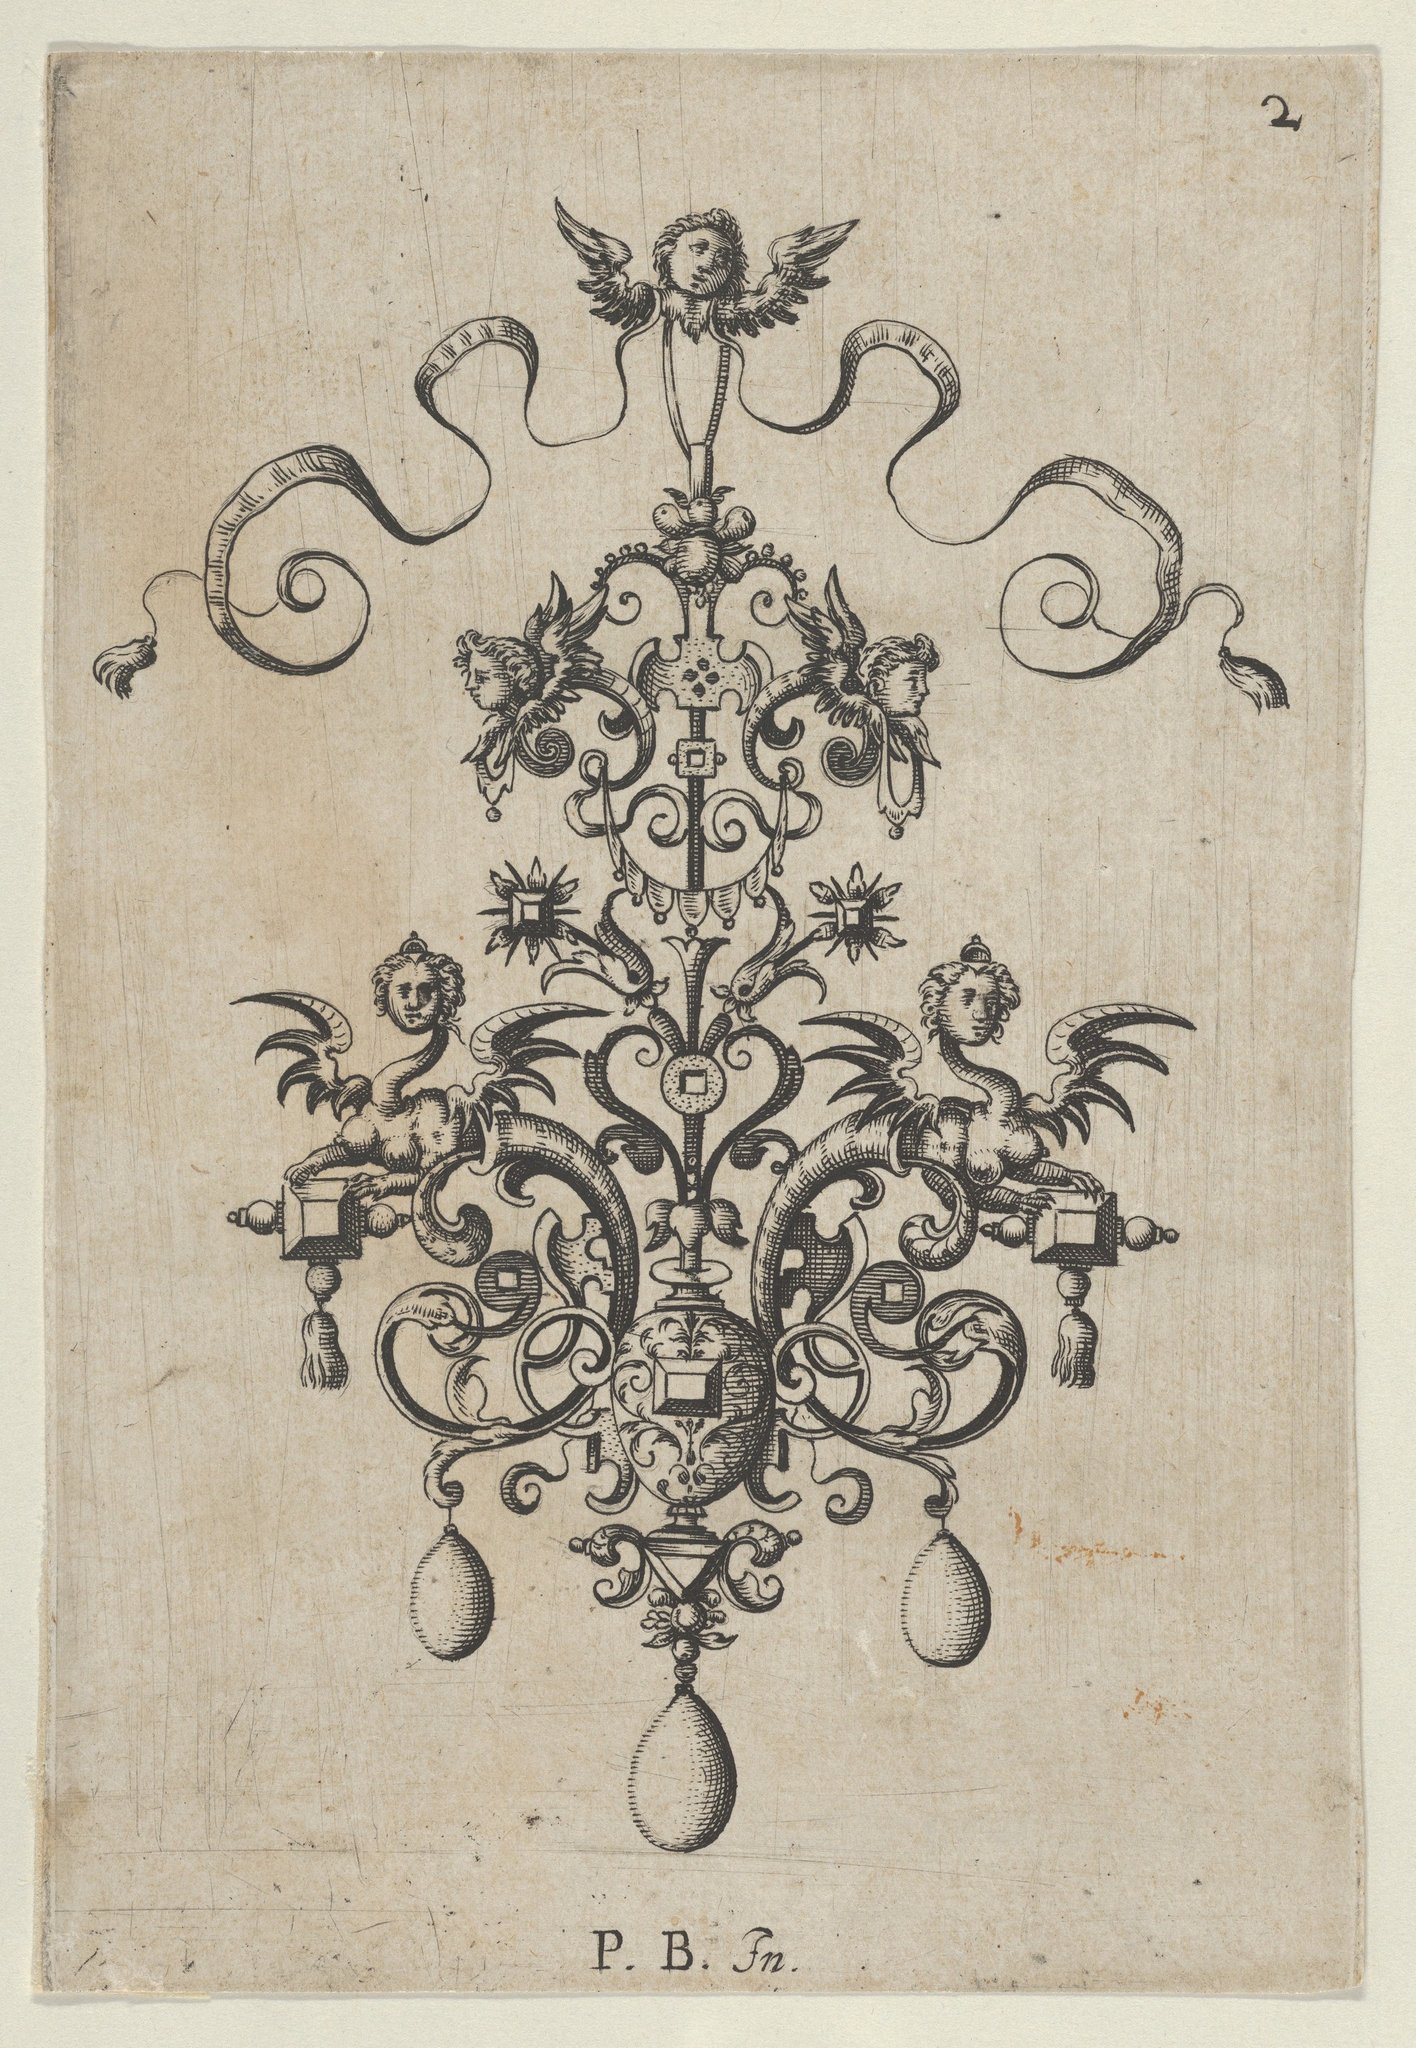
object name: print ornament architecture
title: Reverse Copy of Design for a Pendant, from Ars His Myronis Nobilis Effingitus Pagellulis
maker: paul birckenhultz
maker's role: artist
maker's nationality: german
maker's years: 1561-1639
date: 1600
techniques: engraving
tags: pendants